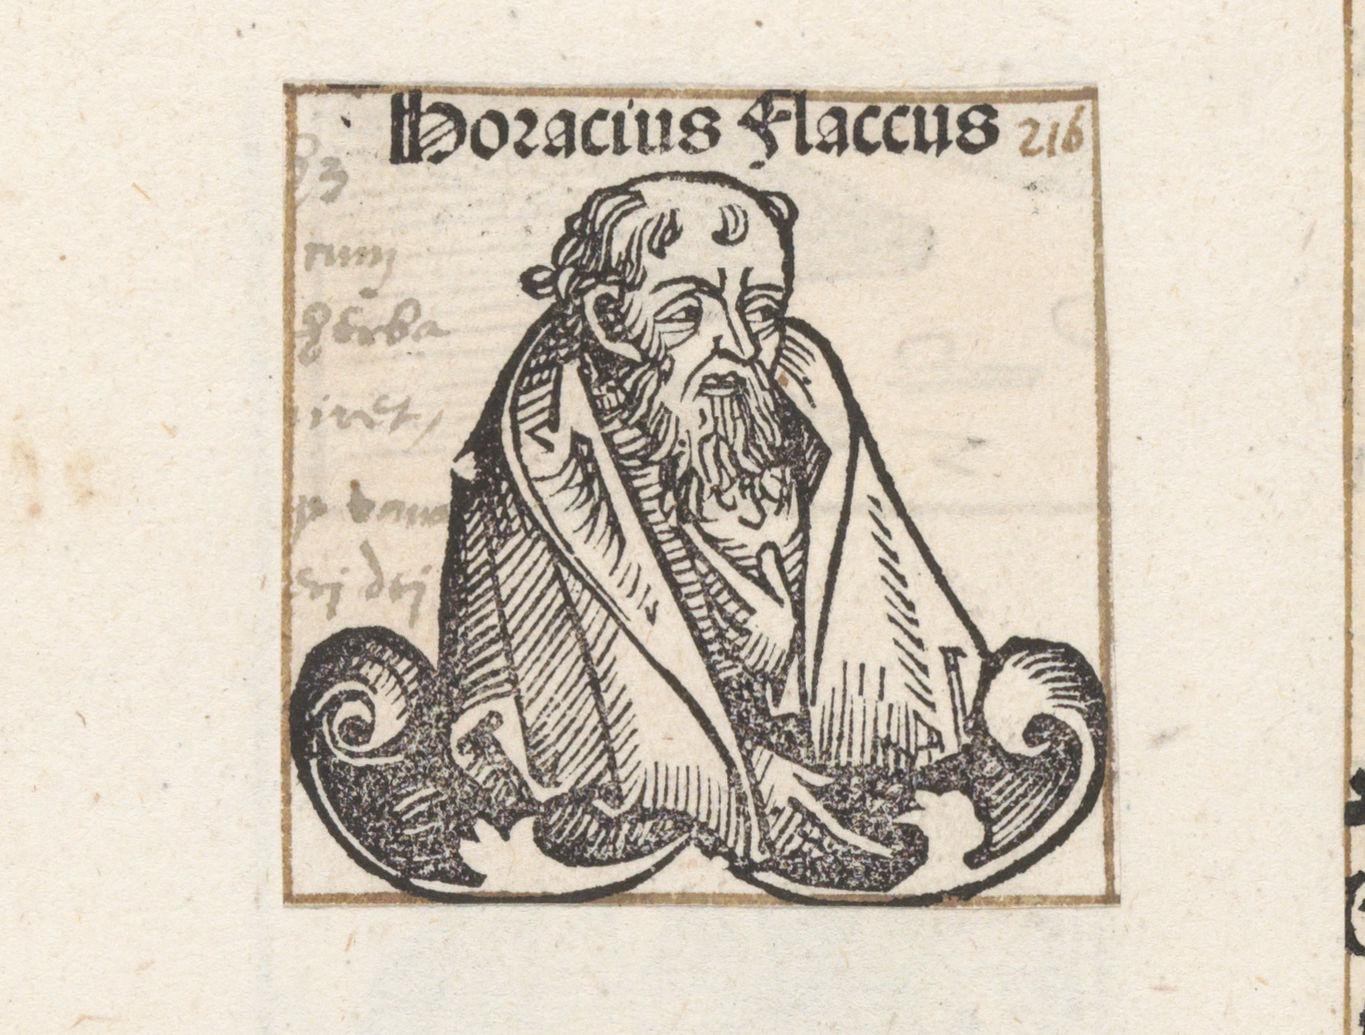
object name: print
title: Liber Chronicarum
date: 1493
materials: paper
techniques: letterpress printing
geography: nuremberg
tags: venosa, rome, horatius, male persons from classical history, writer, poet, author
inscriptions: inscription: ‘216’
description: De houtsnede wordt gebruikt als boekillustratie in de Liber Chronicarum (of Neurenbergkroniek) van Hartmann Schedel, verschenen in het Latijn en Duits in 1493. Zie de Latijnse uitgave, folio 92v.